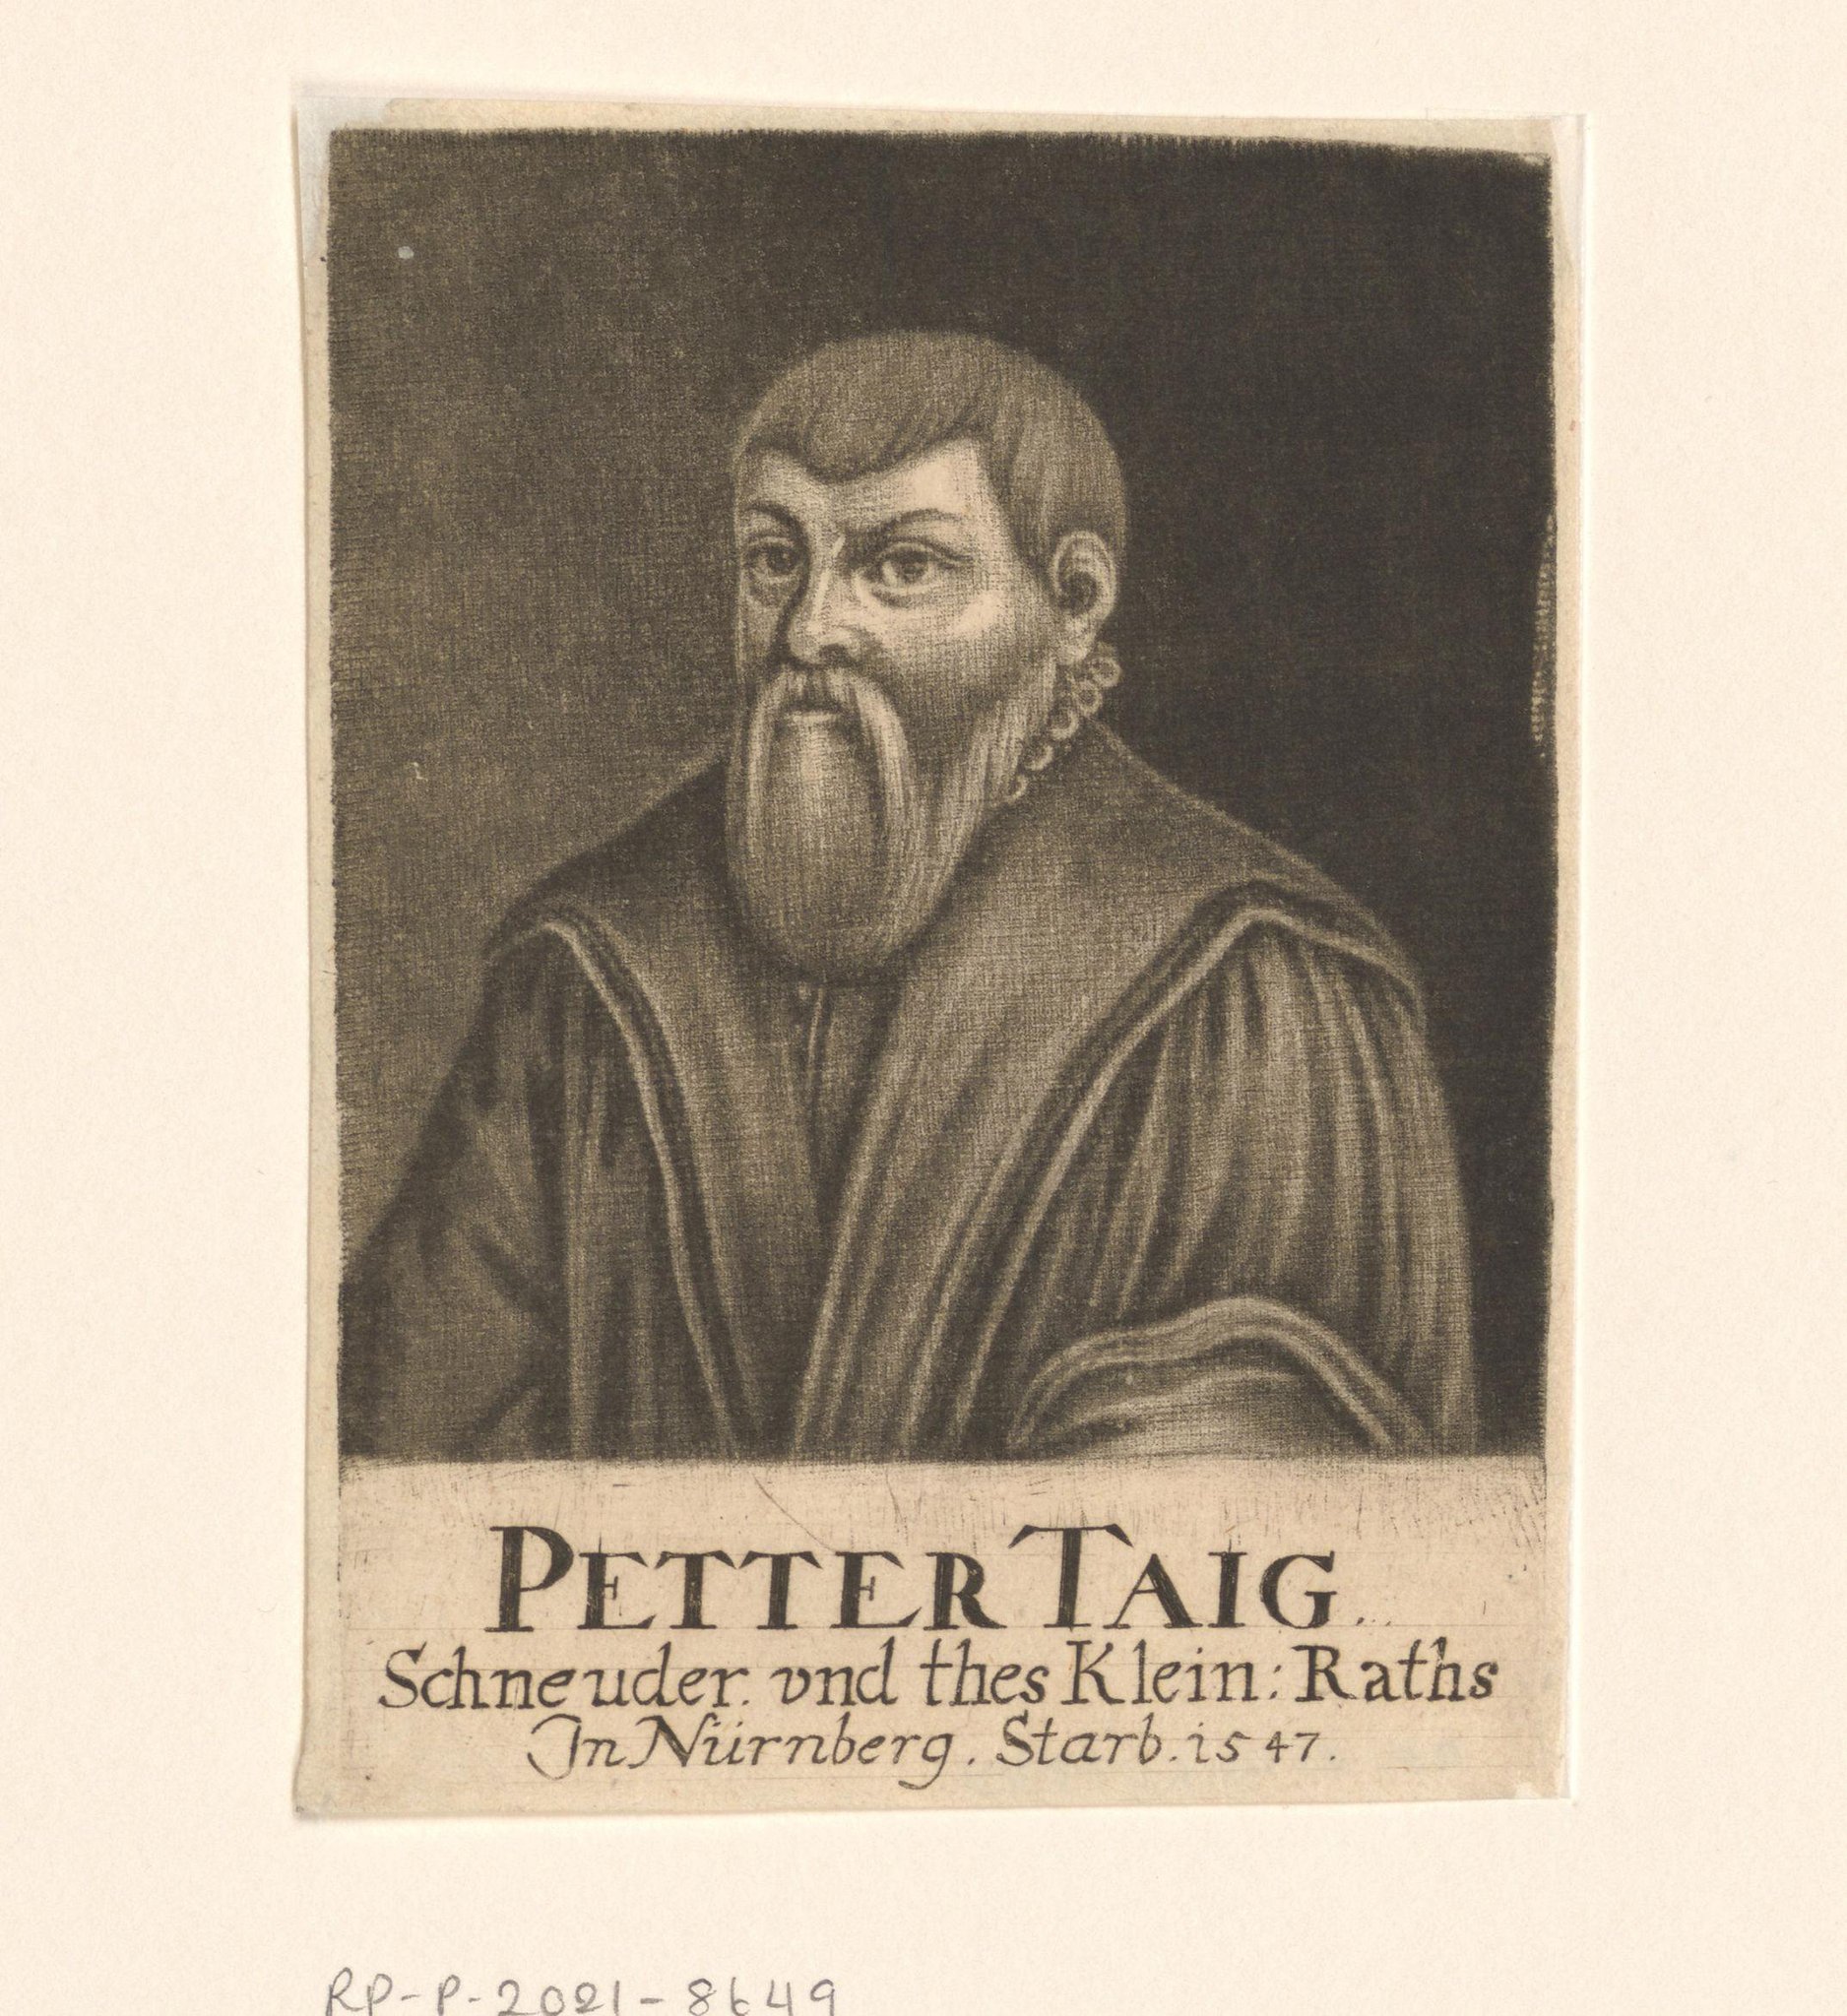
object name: print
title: Portret van Peter Taig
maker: georg fennitzer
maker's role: print maker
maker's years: 1646-1722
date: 1656-1722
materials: paper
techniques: engraving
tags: historical persons